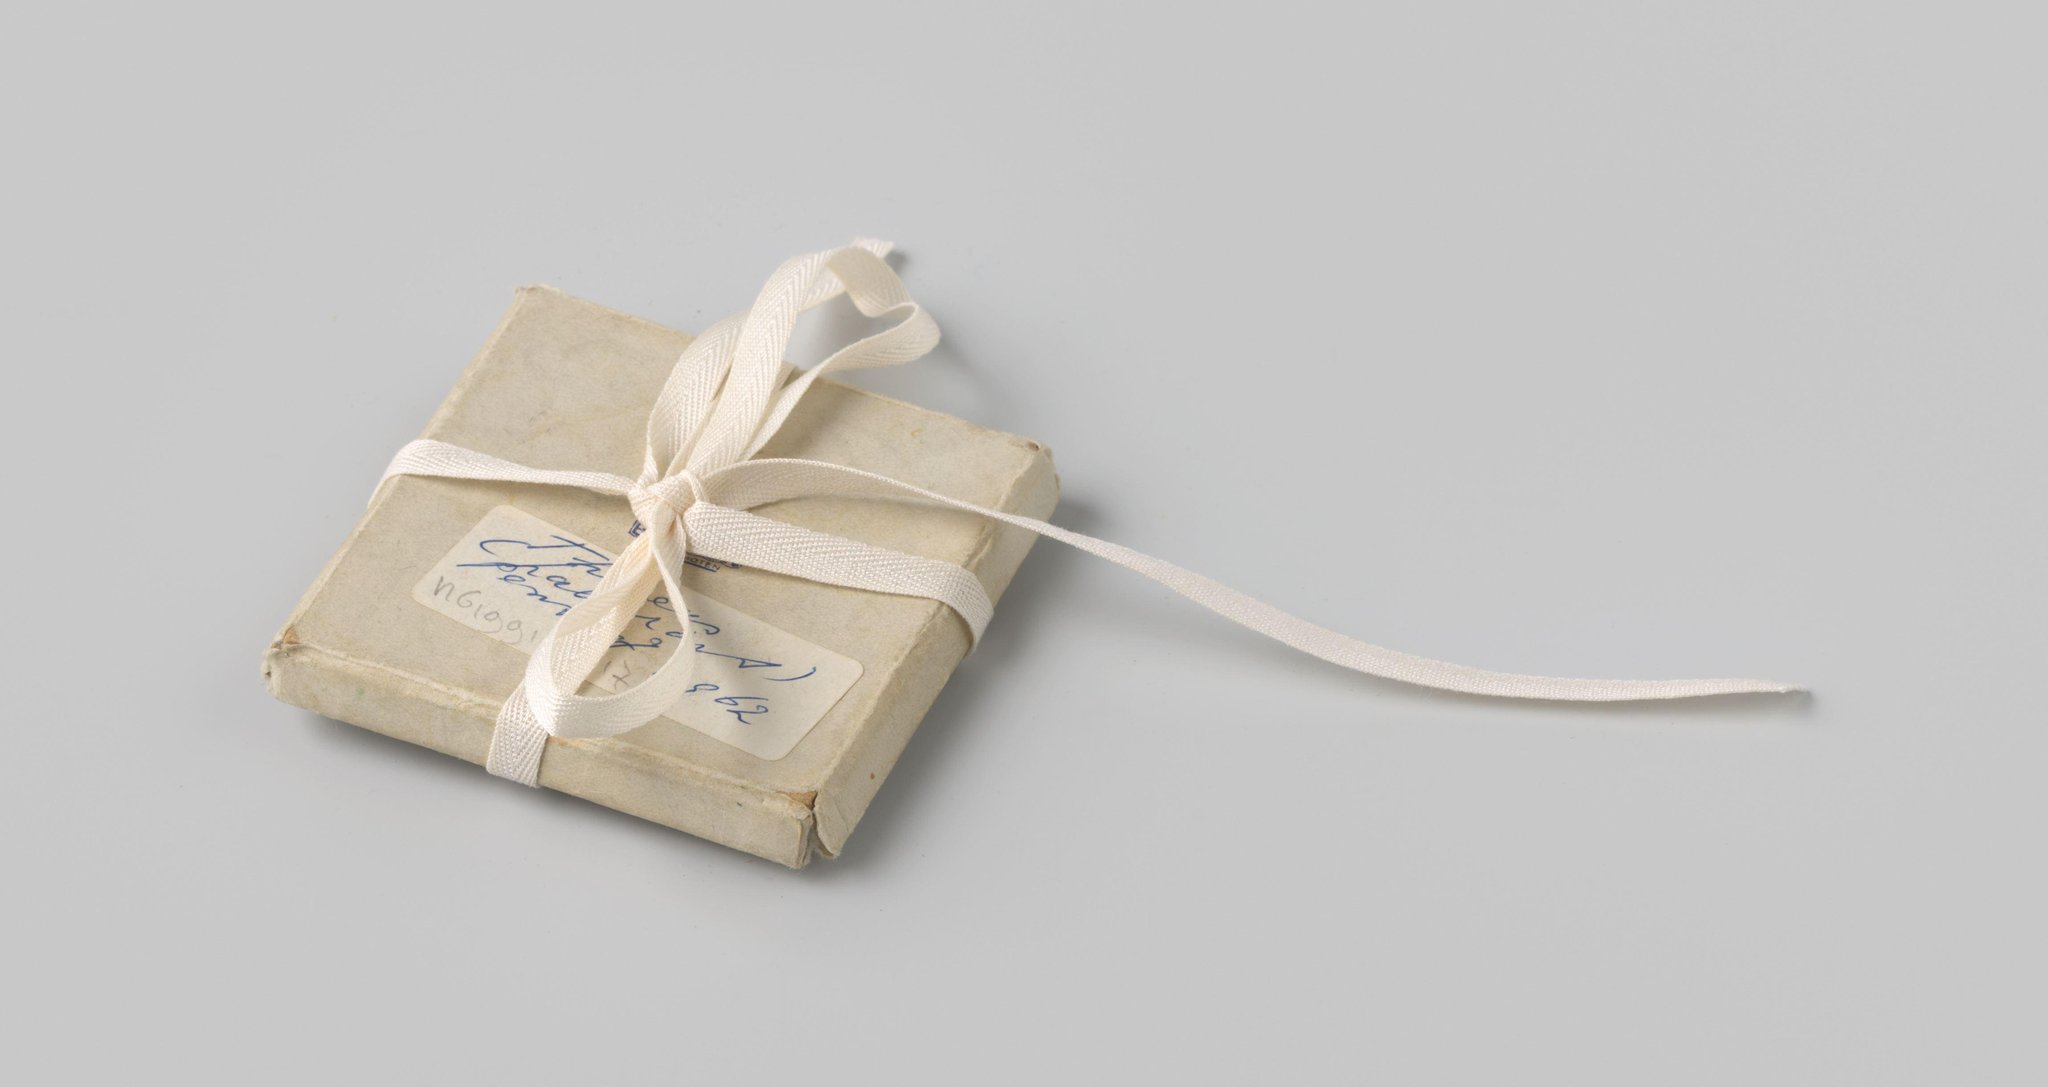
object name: box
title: Vierkant doosje van een Theseus-penning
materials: cardboard, felt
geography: voorschoten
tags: amsterdam, the hague, willem drees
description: Volgens bijgevoegd gedrukt briefje wordt de 'bronzen Theseus' o.a. uitgereikt 'aan clienten bij jubilea of bij enige andere representatieve gebeurtenis'. Op voorzijde van briefje is met pen geschreven: 'Mij overhandigd 16/2/1962'. Zilveren exemplaren van deze penning werden aangeboden aan personen die het werk van de firma sterk hebben bevorderd of aan relaties bij jubilea van 100 jaar en meer. Fa. A.O. Beuth van Wickevoort Crommelin, gevestigd in Amsterdam, is een pensioenadviesbureau.